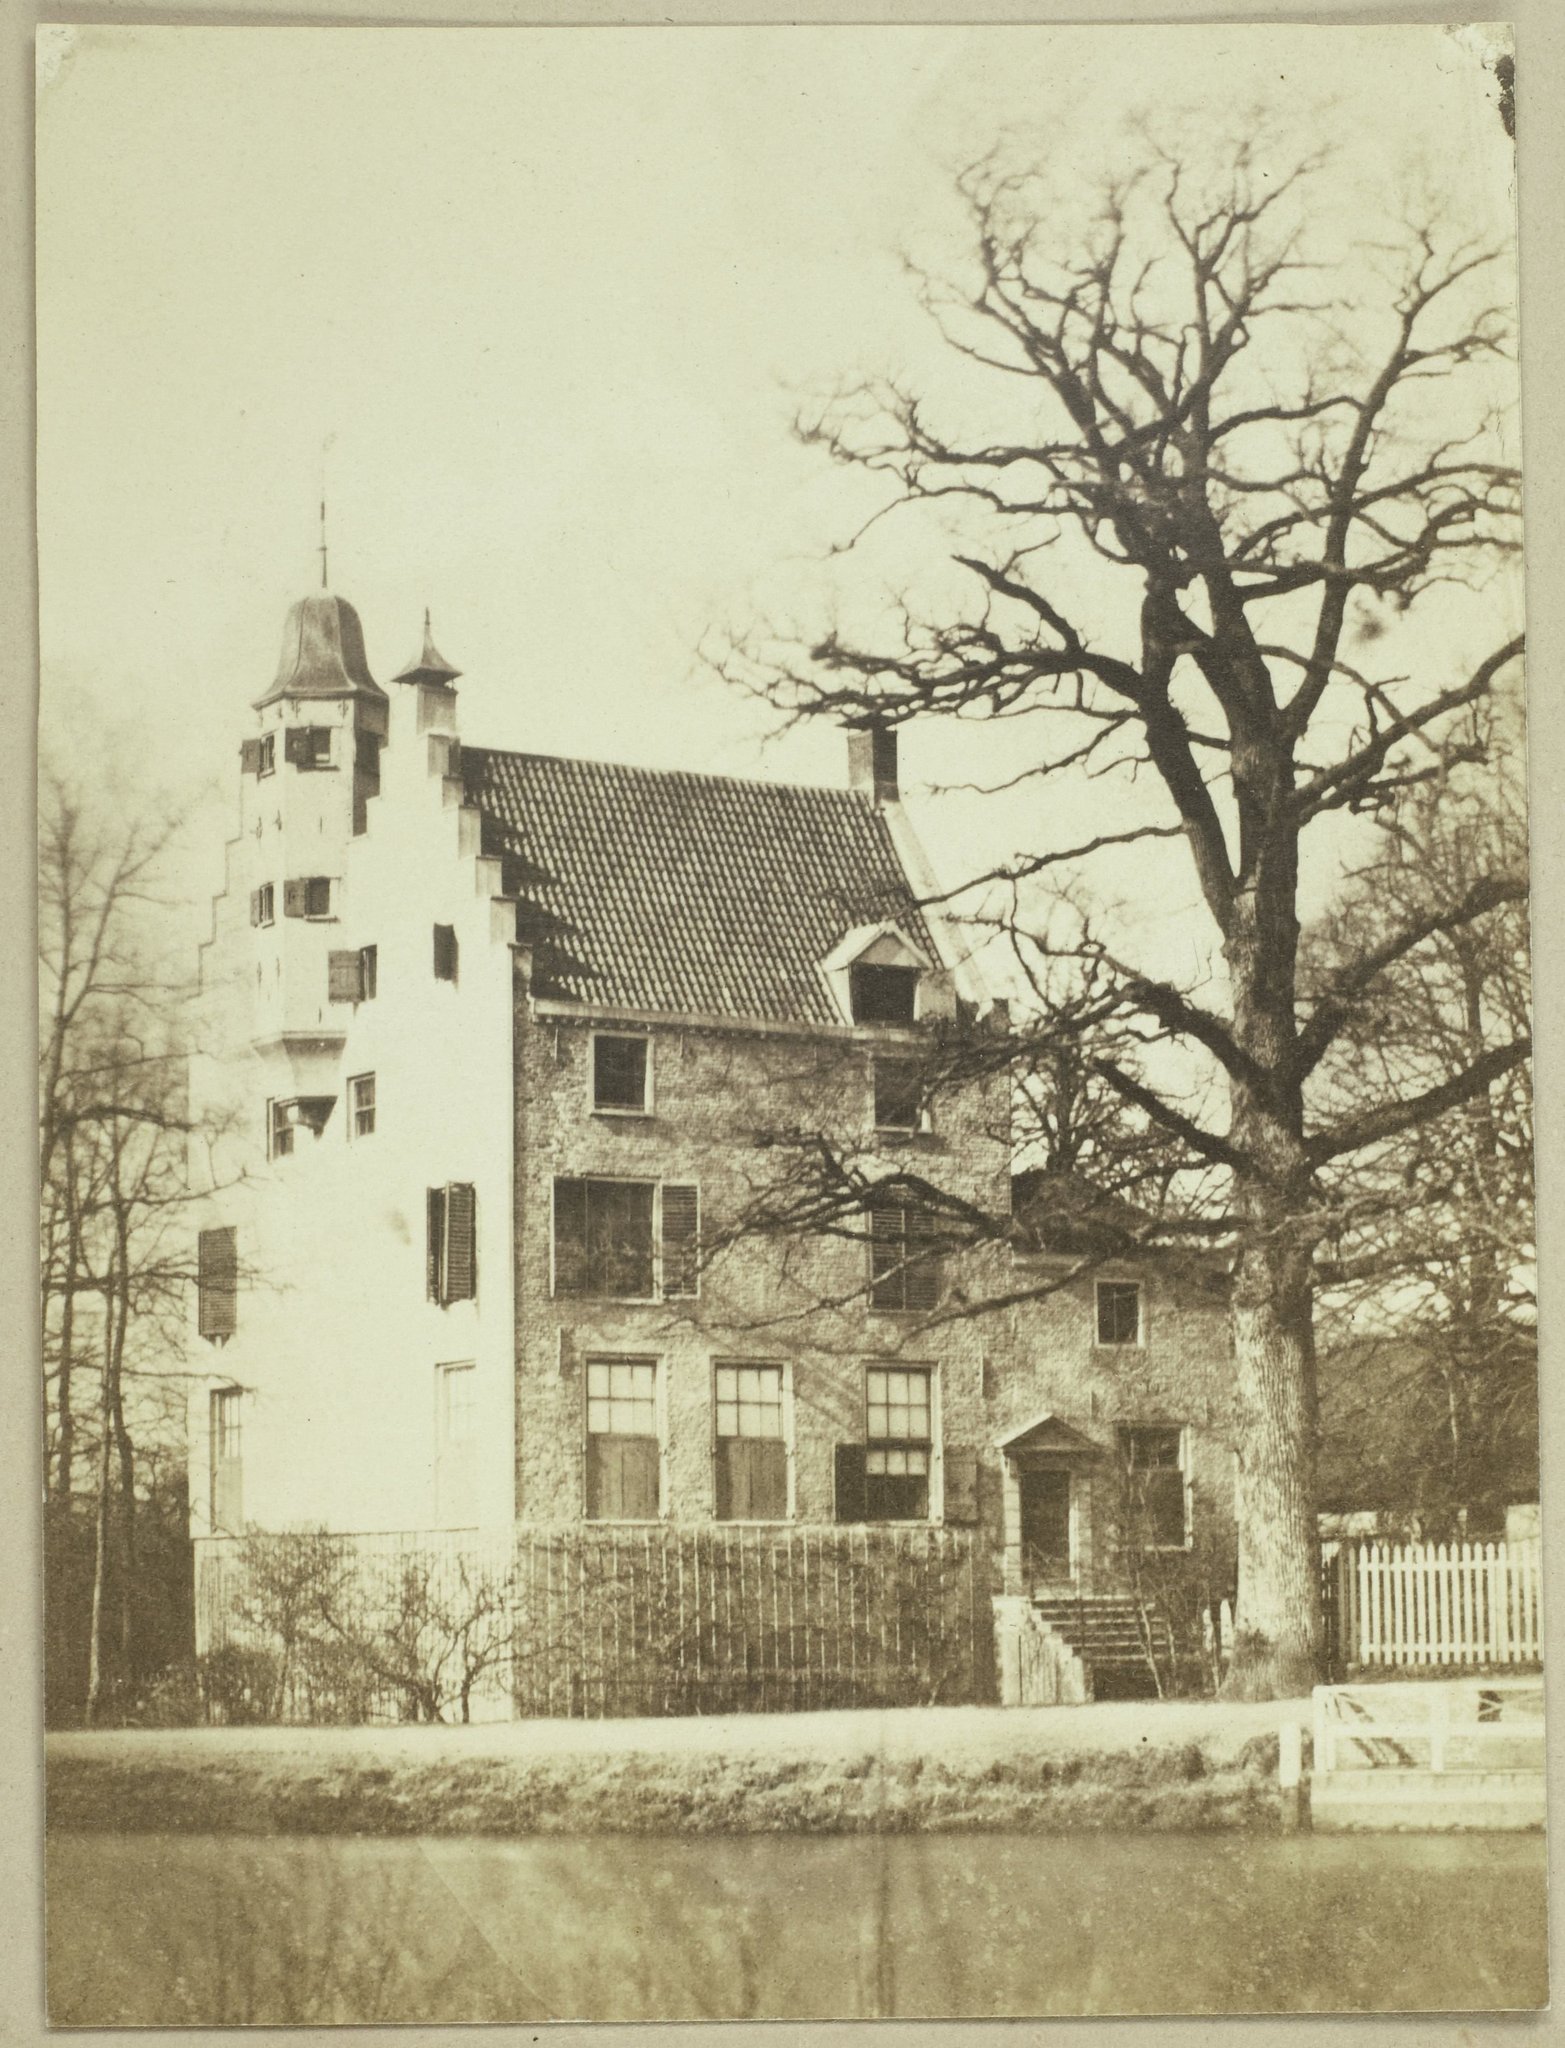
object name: photograph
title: Gezicht op huis Oudaan bij Breukelen aan de Vecht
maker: eduard isaac asser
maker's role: amateurfotograaf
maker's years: 1809-1894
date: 1853-1854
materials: cardboard, paper, photographic support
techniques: salted paper print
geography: amsterdam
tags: breukelen